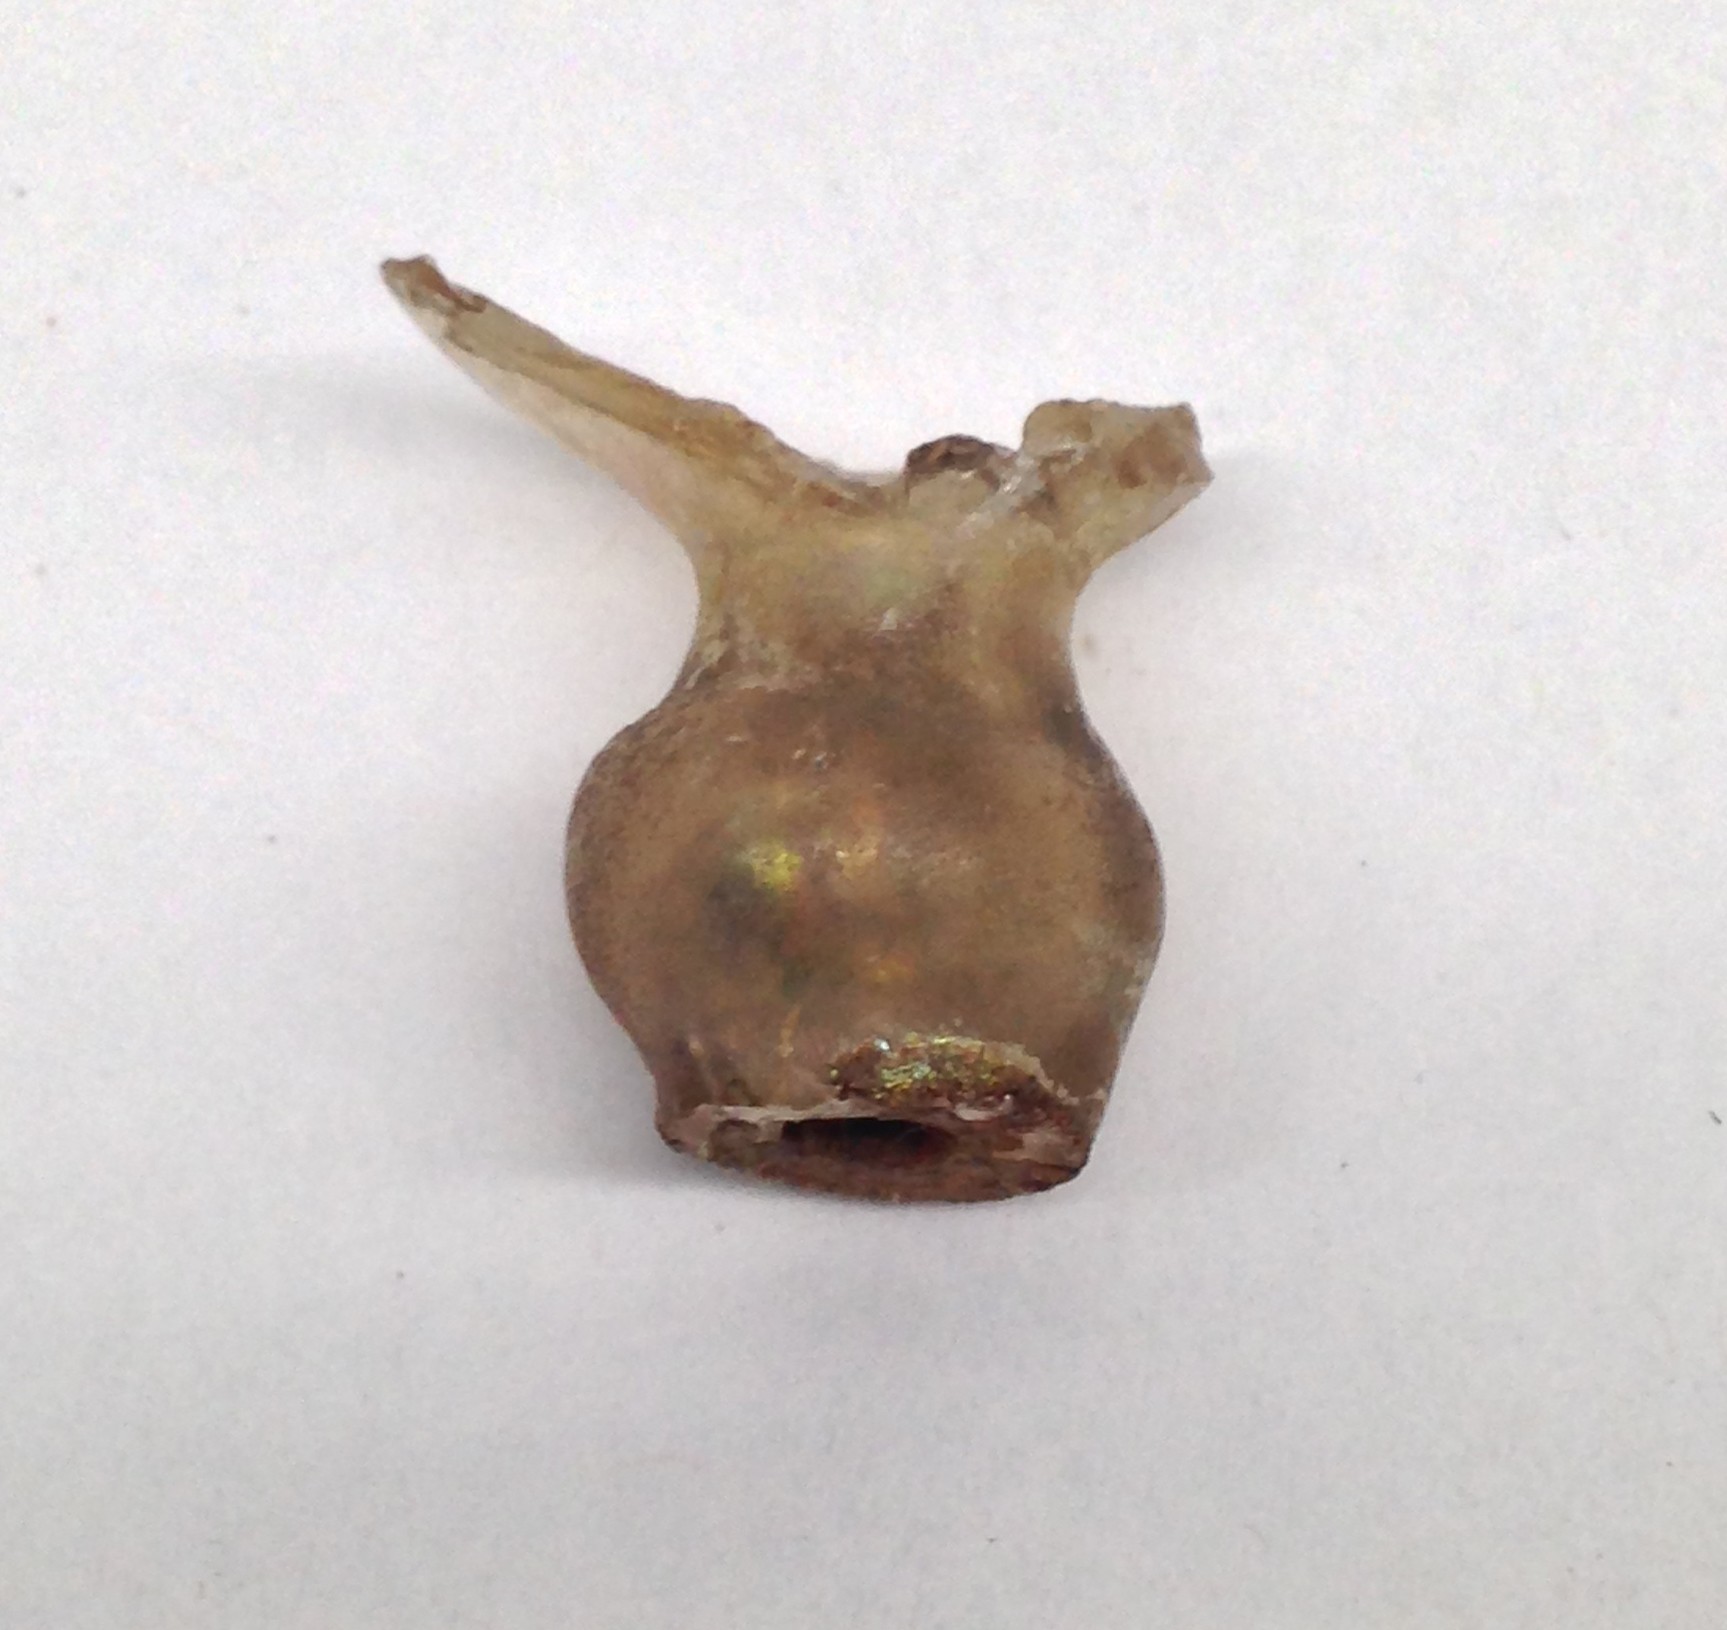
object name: fragment of flask neck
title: Fragment of Flask Necks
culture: french or german or syrian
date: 1201-1300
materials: glass